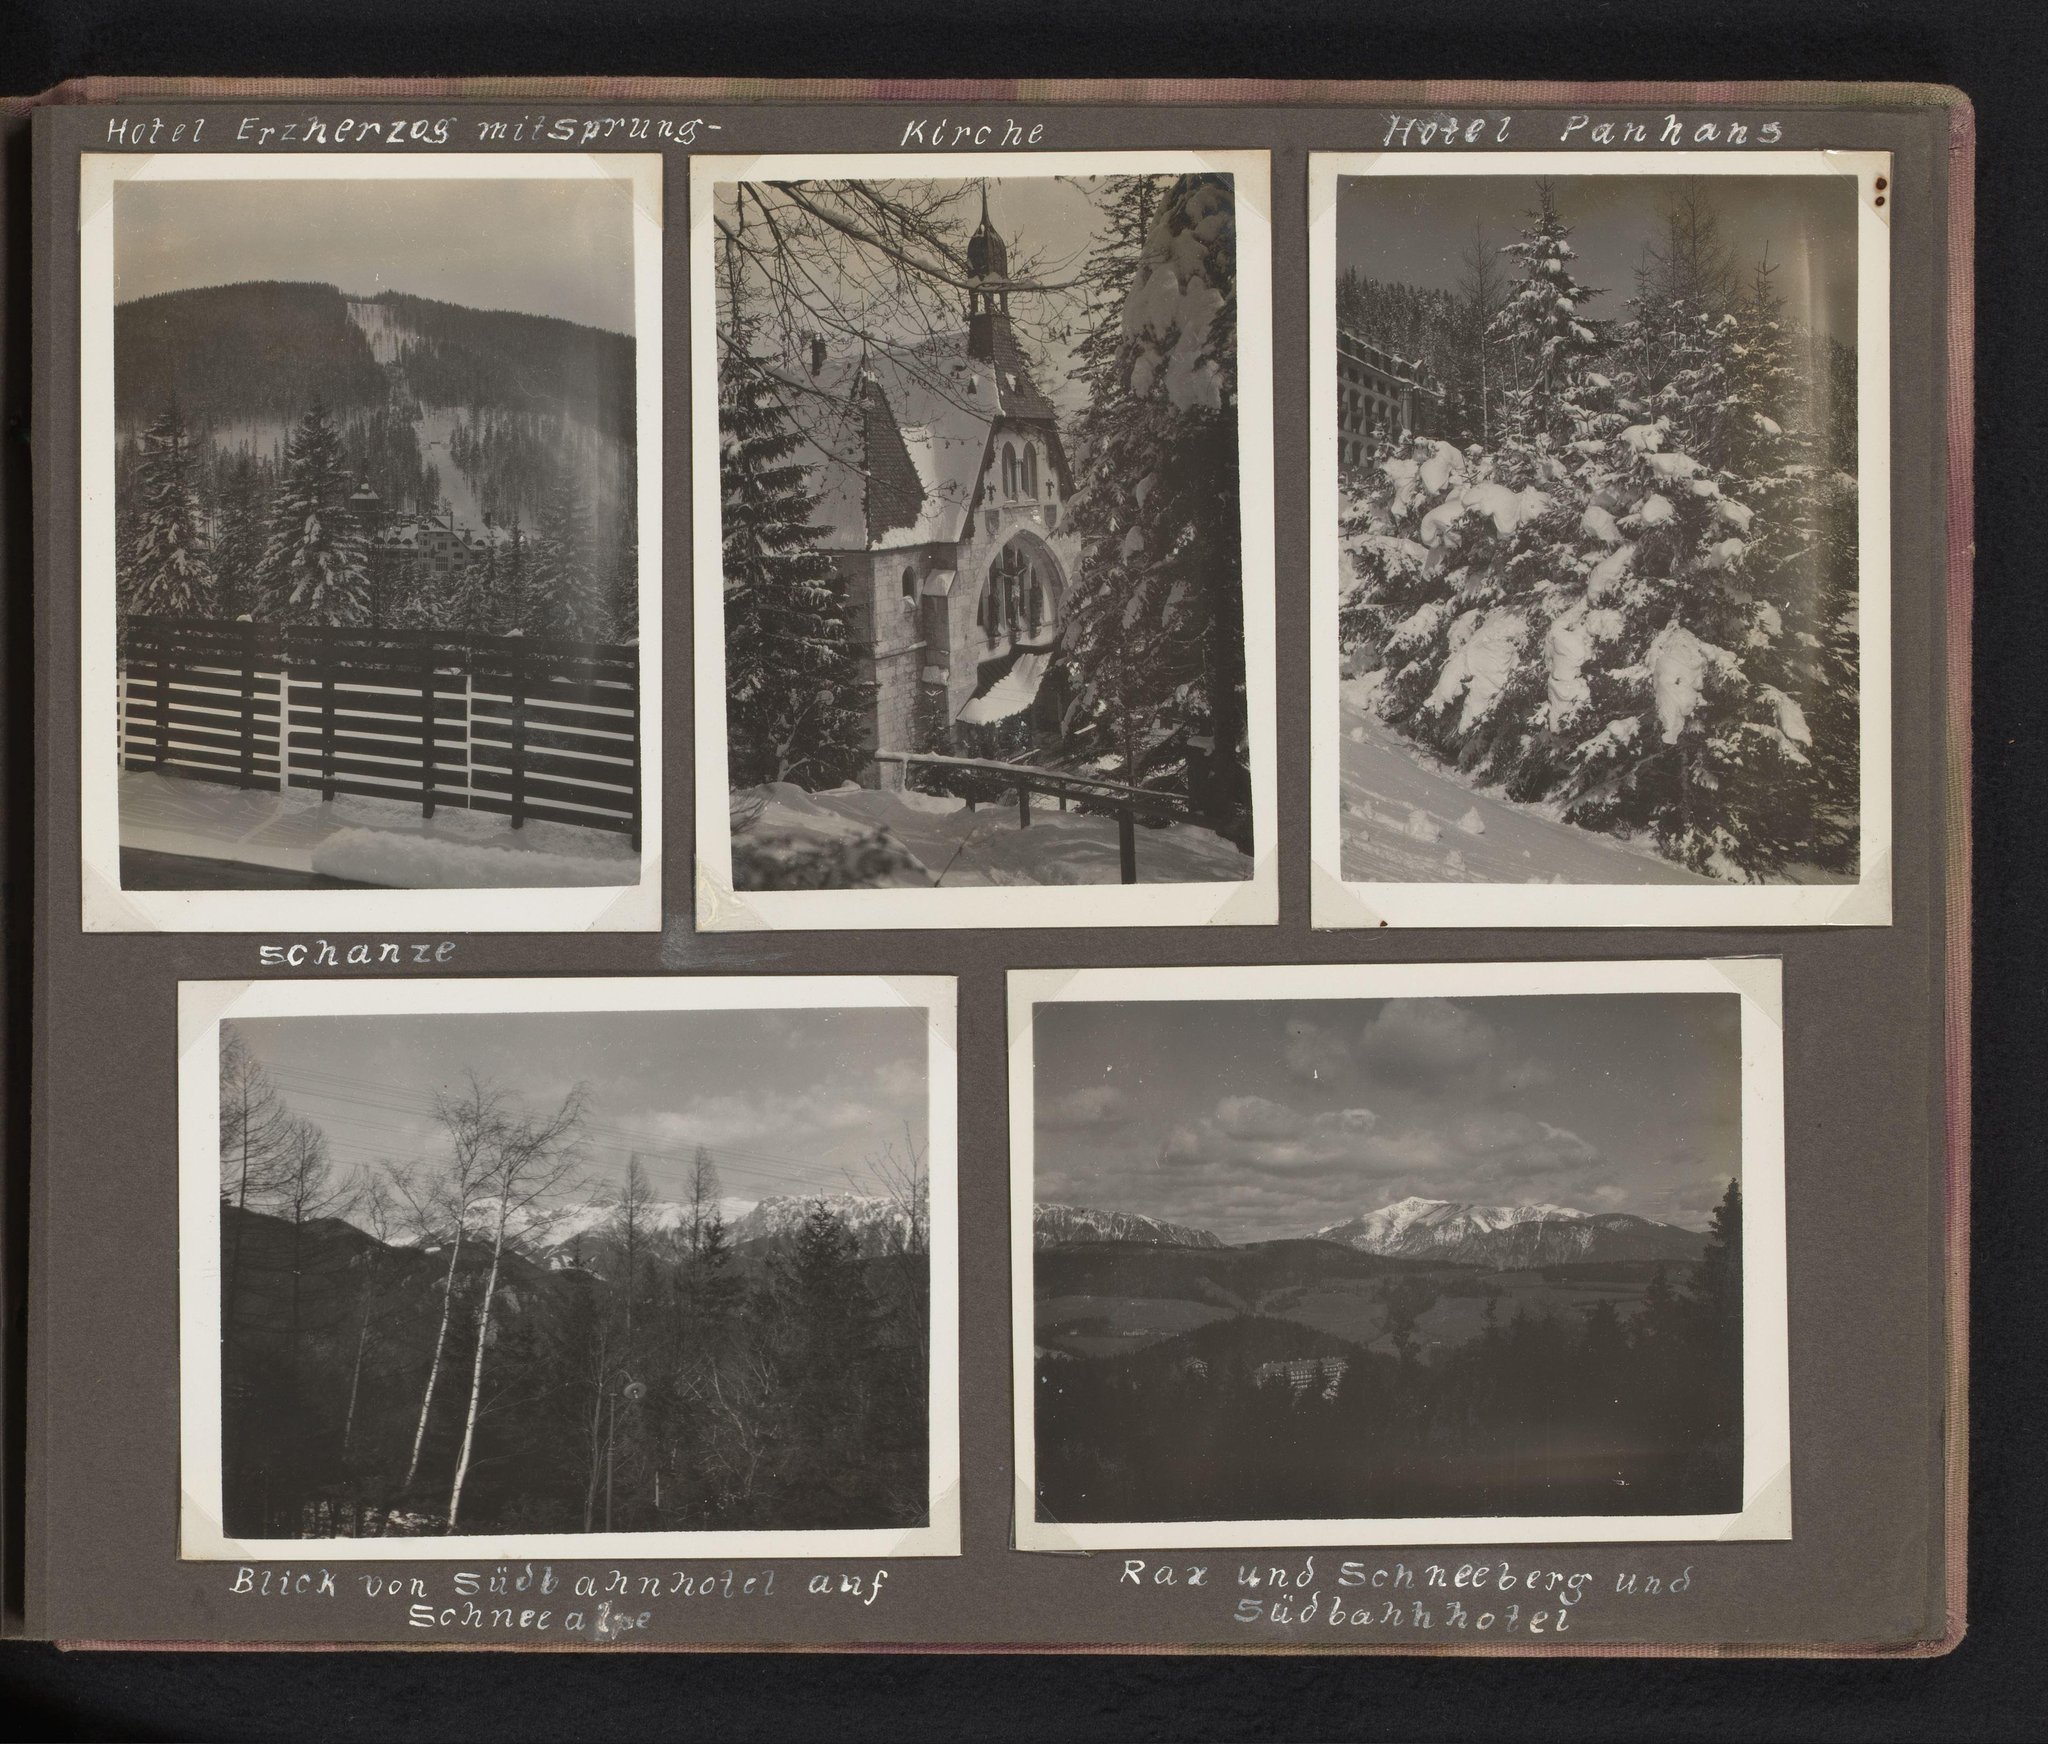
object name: album leaf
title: Wintersportvakantie in Semmering, Oostenrijk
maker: berti hoppe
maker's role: fotograaf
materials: cardboard, photographic support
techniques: gelatin silver print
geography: semmering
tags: church (exterior), winter landscape; landscape symbolizing winter (the four seasons of the year), hotel, hostelry, inn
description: Vijf winterlandschappen met gebouwen in Semmering. In de onderschriften is vermeld dat het gaat om Hotel Erzherzog Johann, een kerk, Hotel Panhans en het Südbahnhotel. Deze foto's maken deel uit van een album.